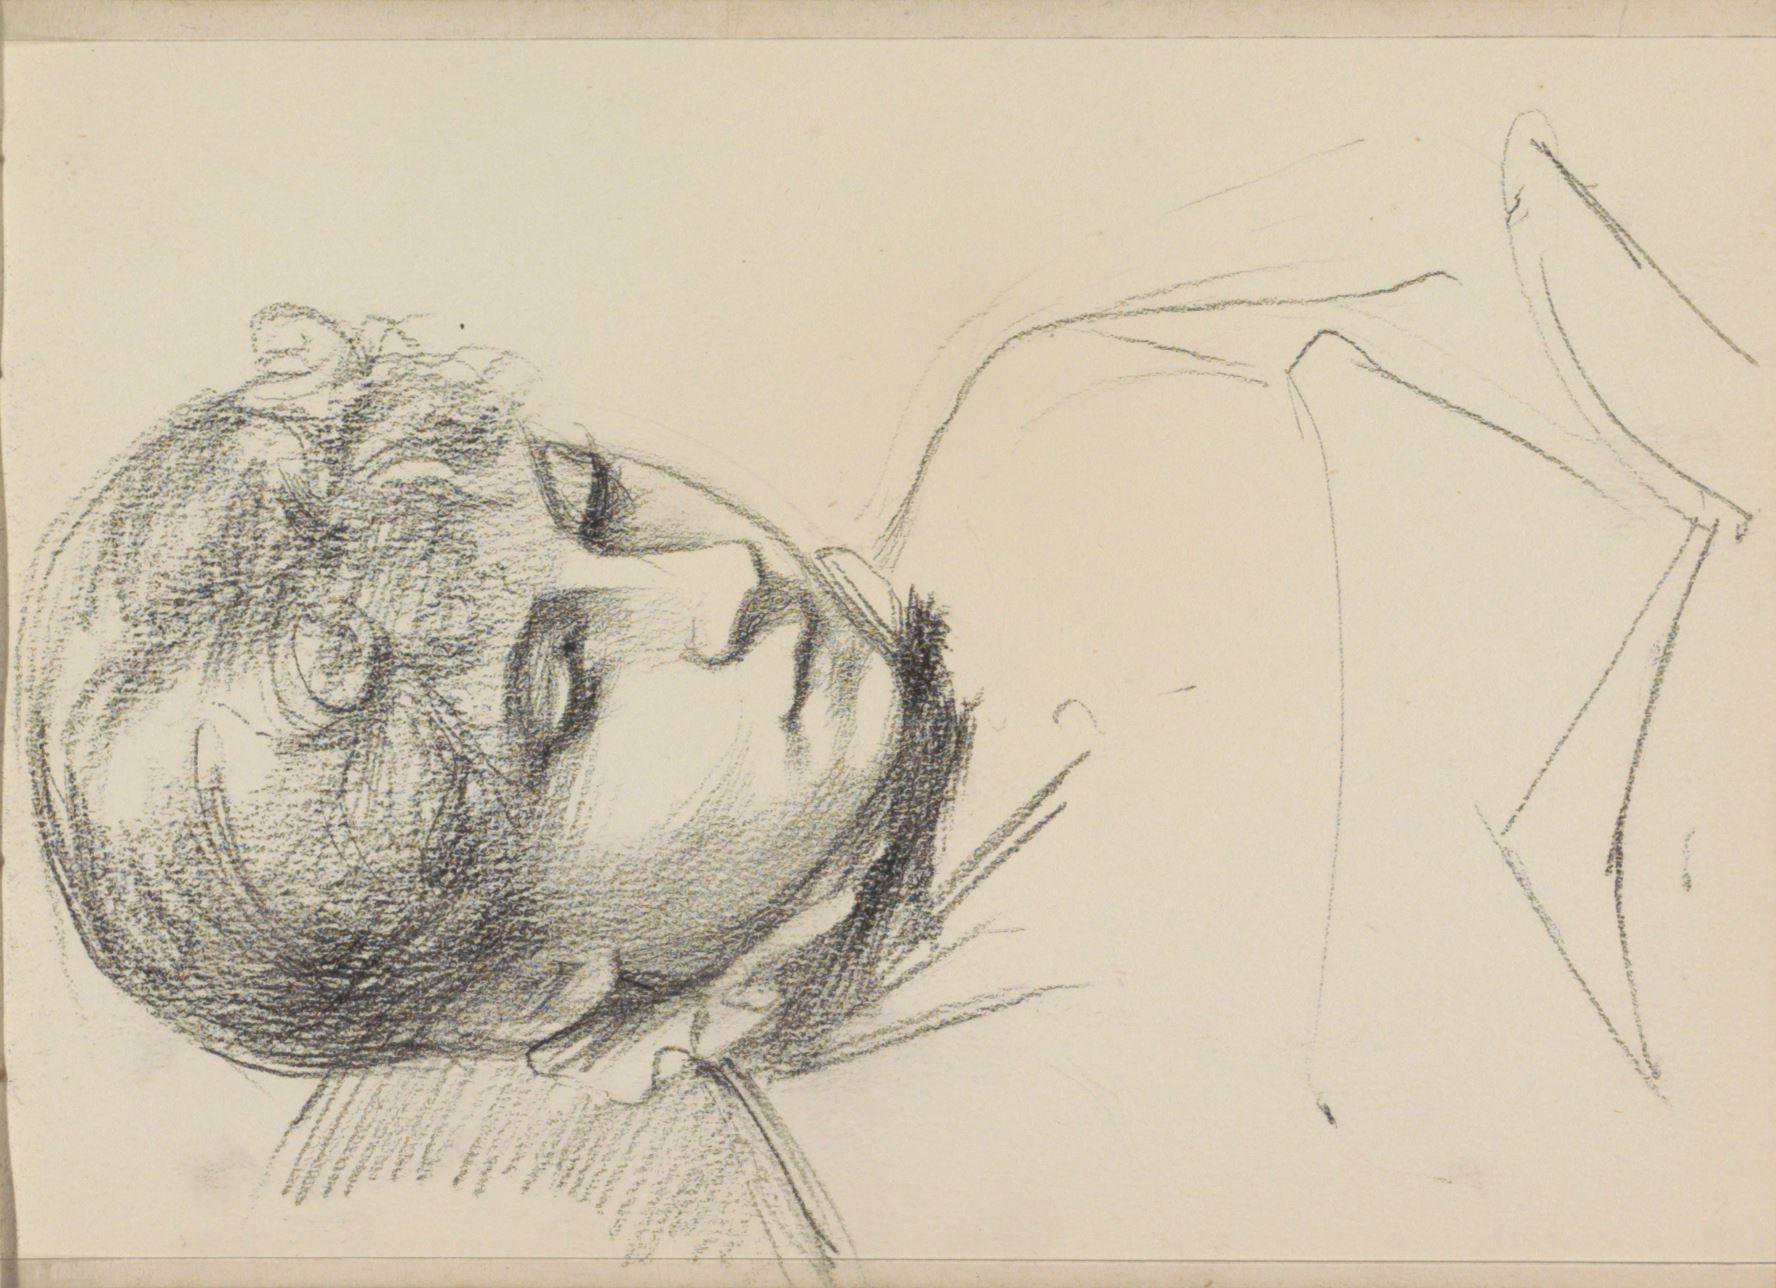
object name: sketchbook leaf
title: Lezend meisje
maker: a.a.l. de grammont-hubrecht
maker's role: draughtsman, painter, print maker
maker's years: 1855-1913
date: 1865-1913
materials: chalk, paper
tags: reading, girl (child between toddler and youth)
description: Blad 14 recto uit een schetsboek met 38 bladen.